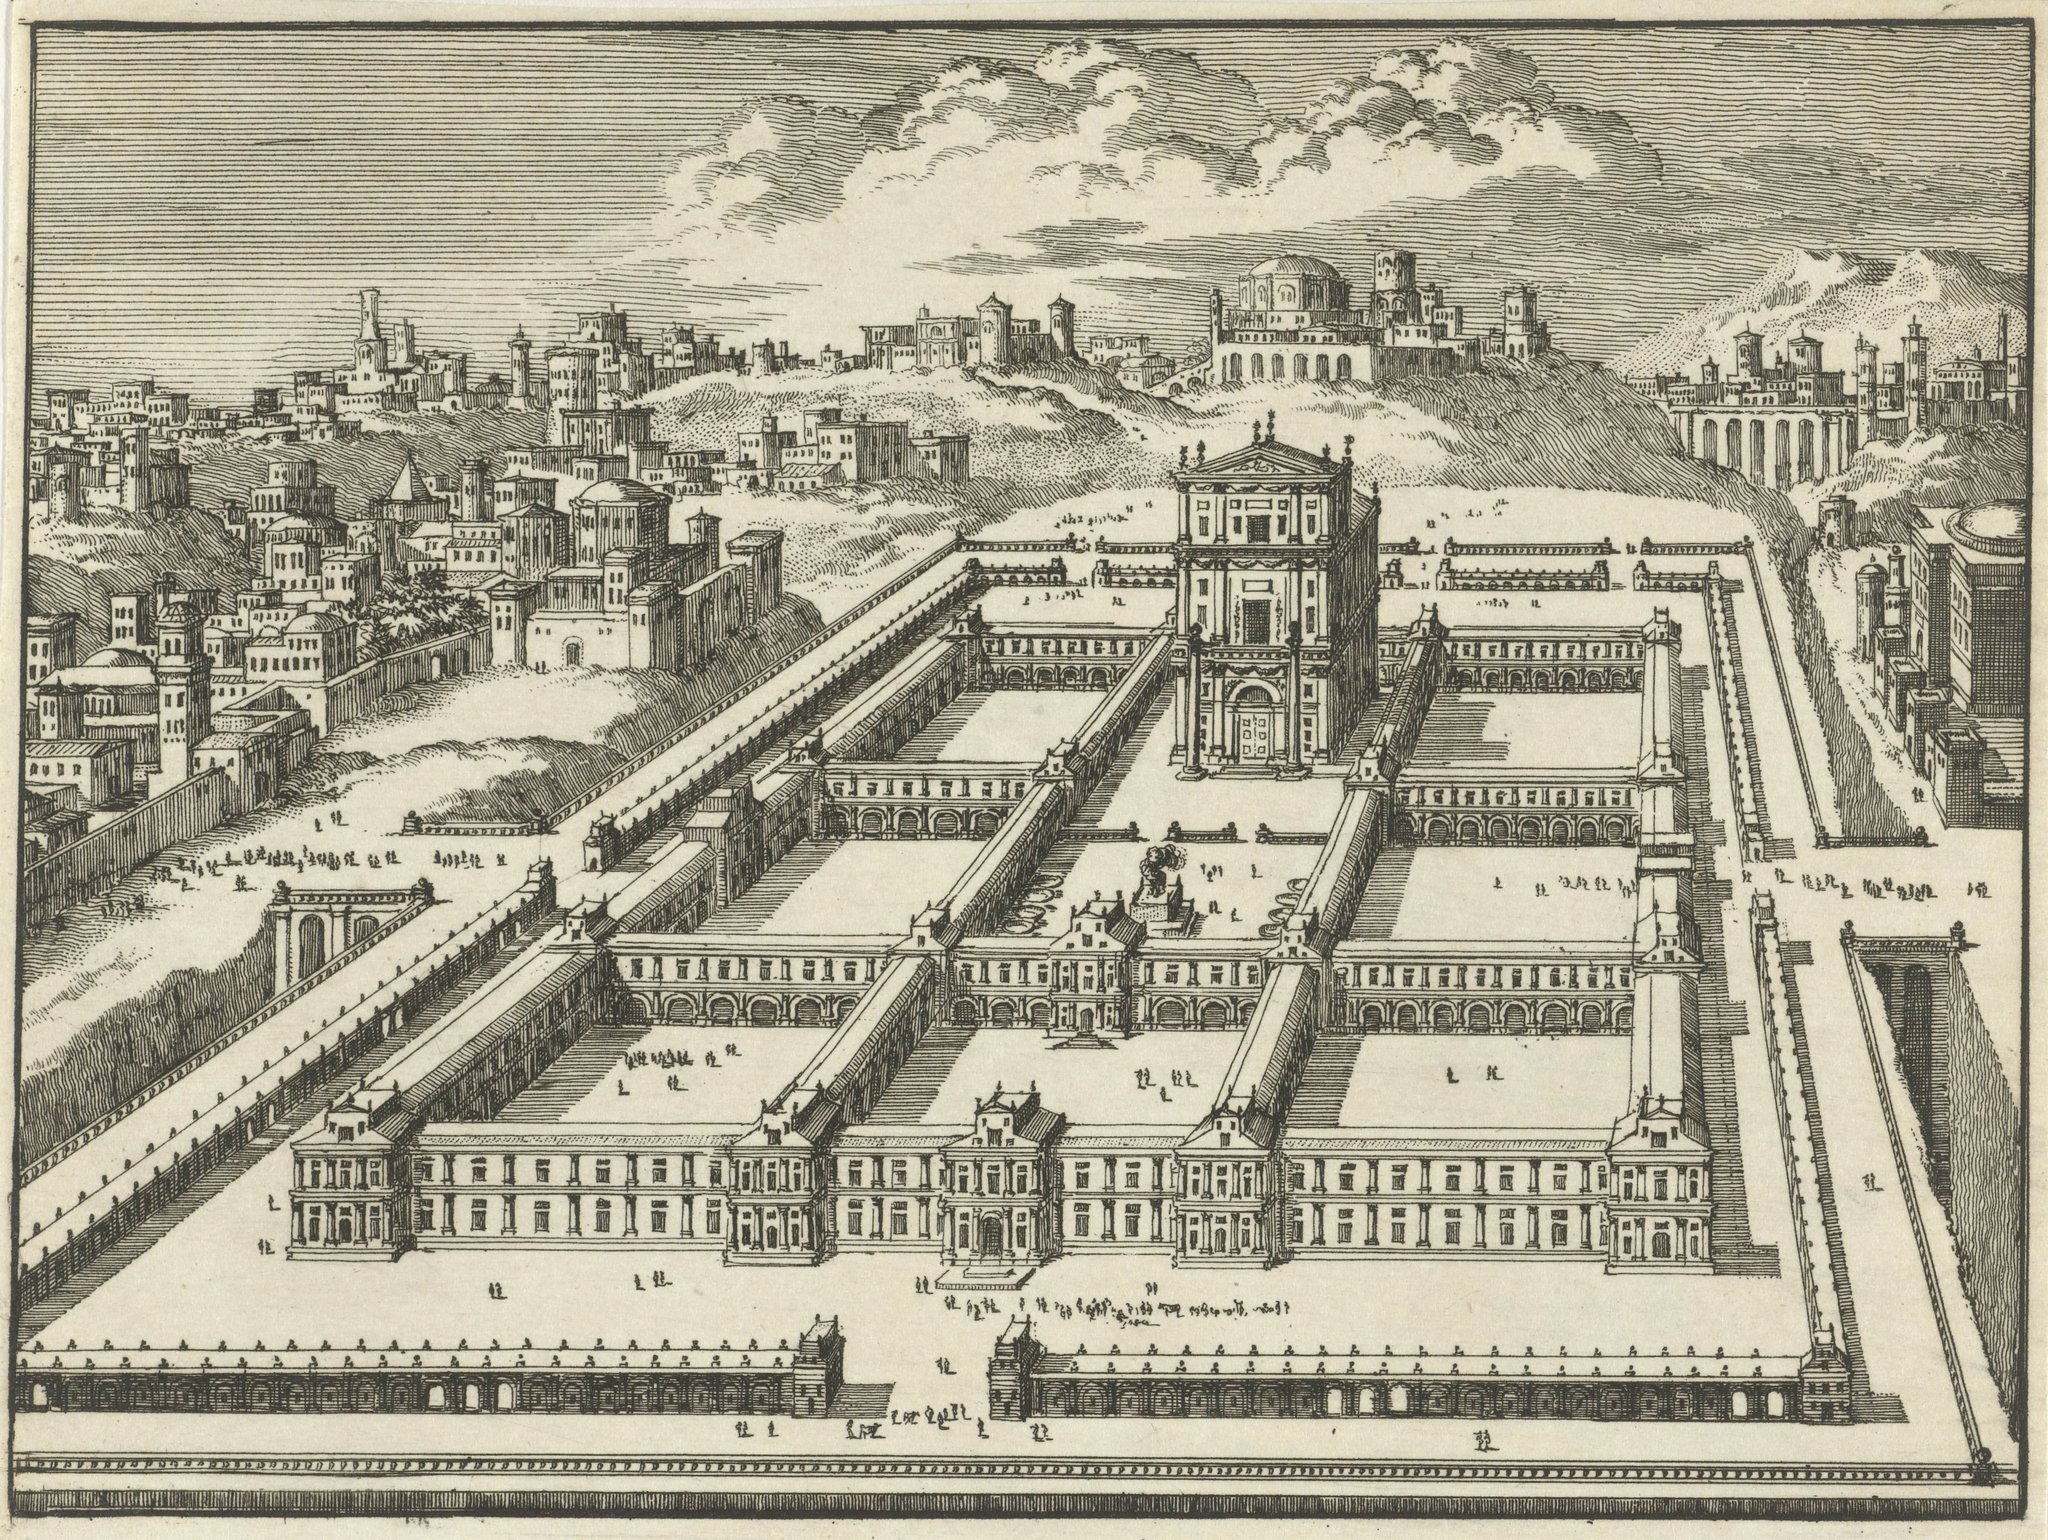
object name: print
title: Tempel van Salomon, Jeruzalem (variant B)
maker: jan luyken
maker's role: draughtsman, print maker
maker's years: 1649-1712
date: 1669-1712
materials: paper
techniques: etching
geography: amsterdam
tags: temple of solomon (1 kings 5-9; 2 chronicles 2-7)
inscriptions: collector's mark: Lugt 2228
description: Variant van deze illustratie opgenomen in: Cunaeus, Petrus. De republyk der Hebreen, of gemeenebest der joden, 3 delen. Amsterdam: Wilhelmus Goeree, 1682, dl. 1, p. 226.